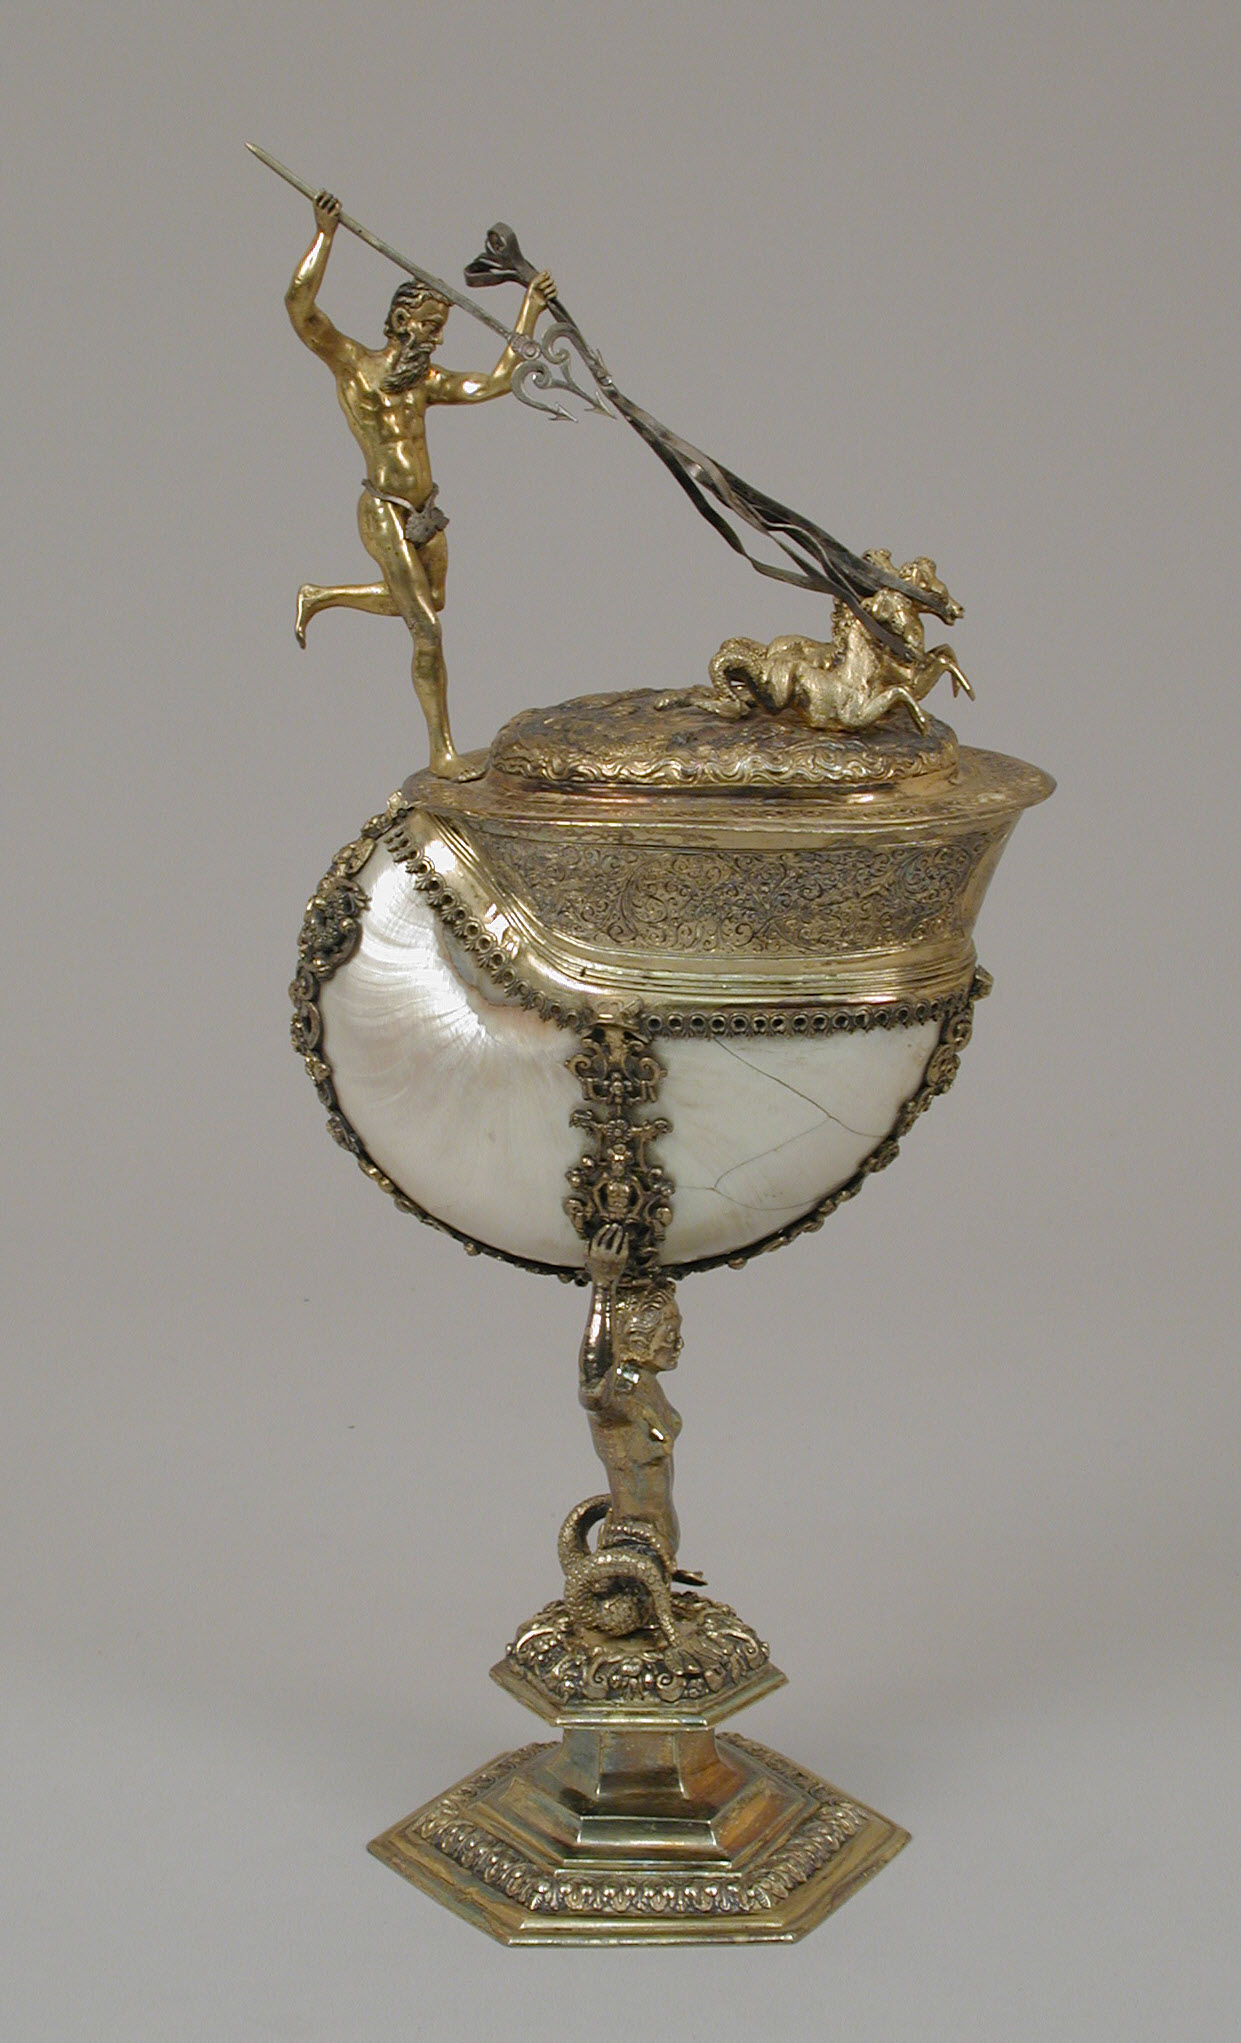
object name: nautilus cup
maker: friedrich hillebrand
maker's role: artist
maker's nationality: german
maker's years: 1580-1608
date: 1801-1900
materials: shell, silver gilt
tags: spears,men,horses